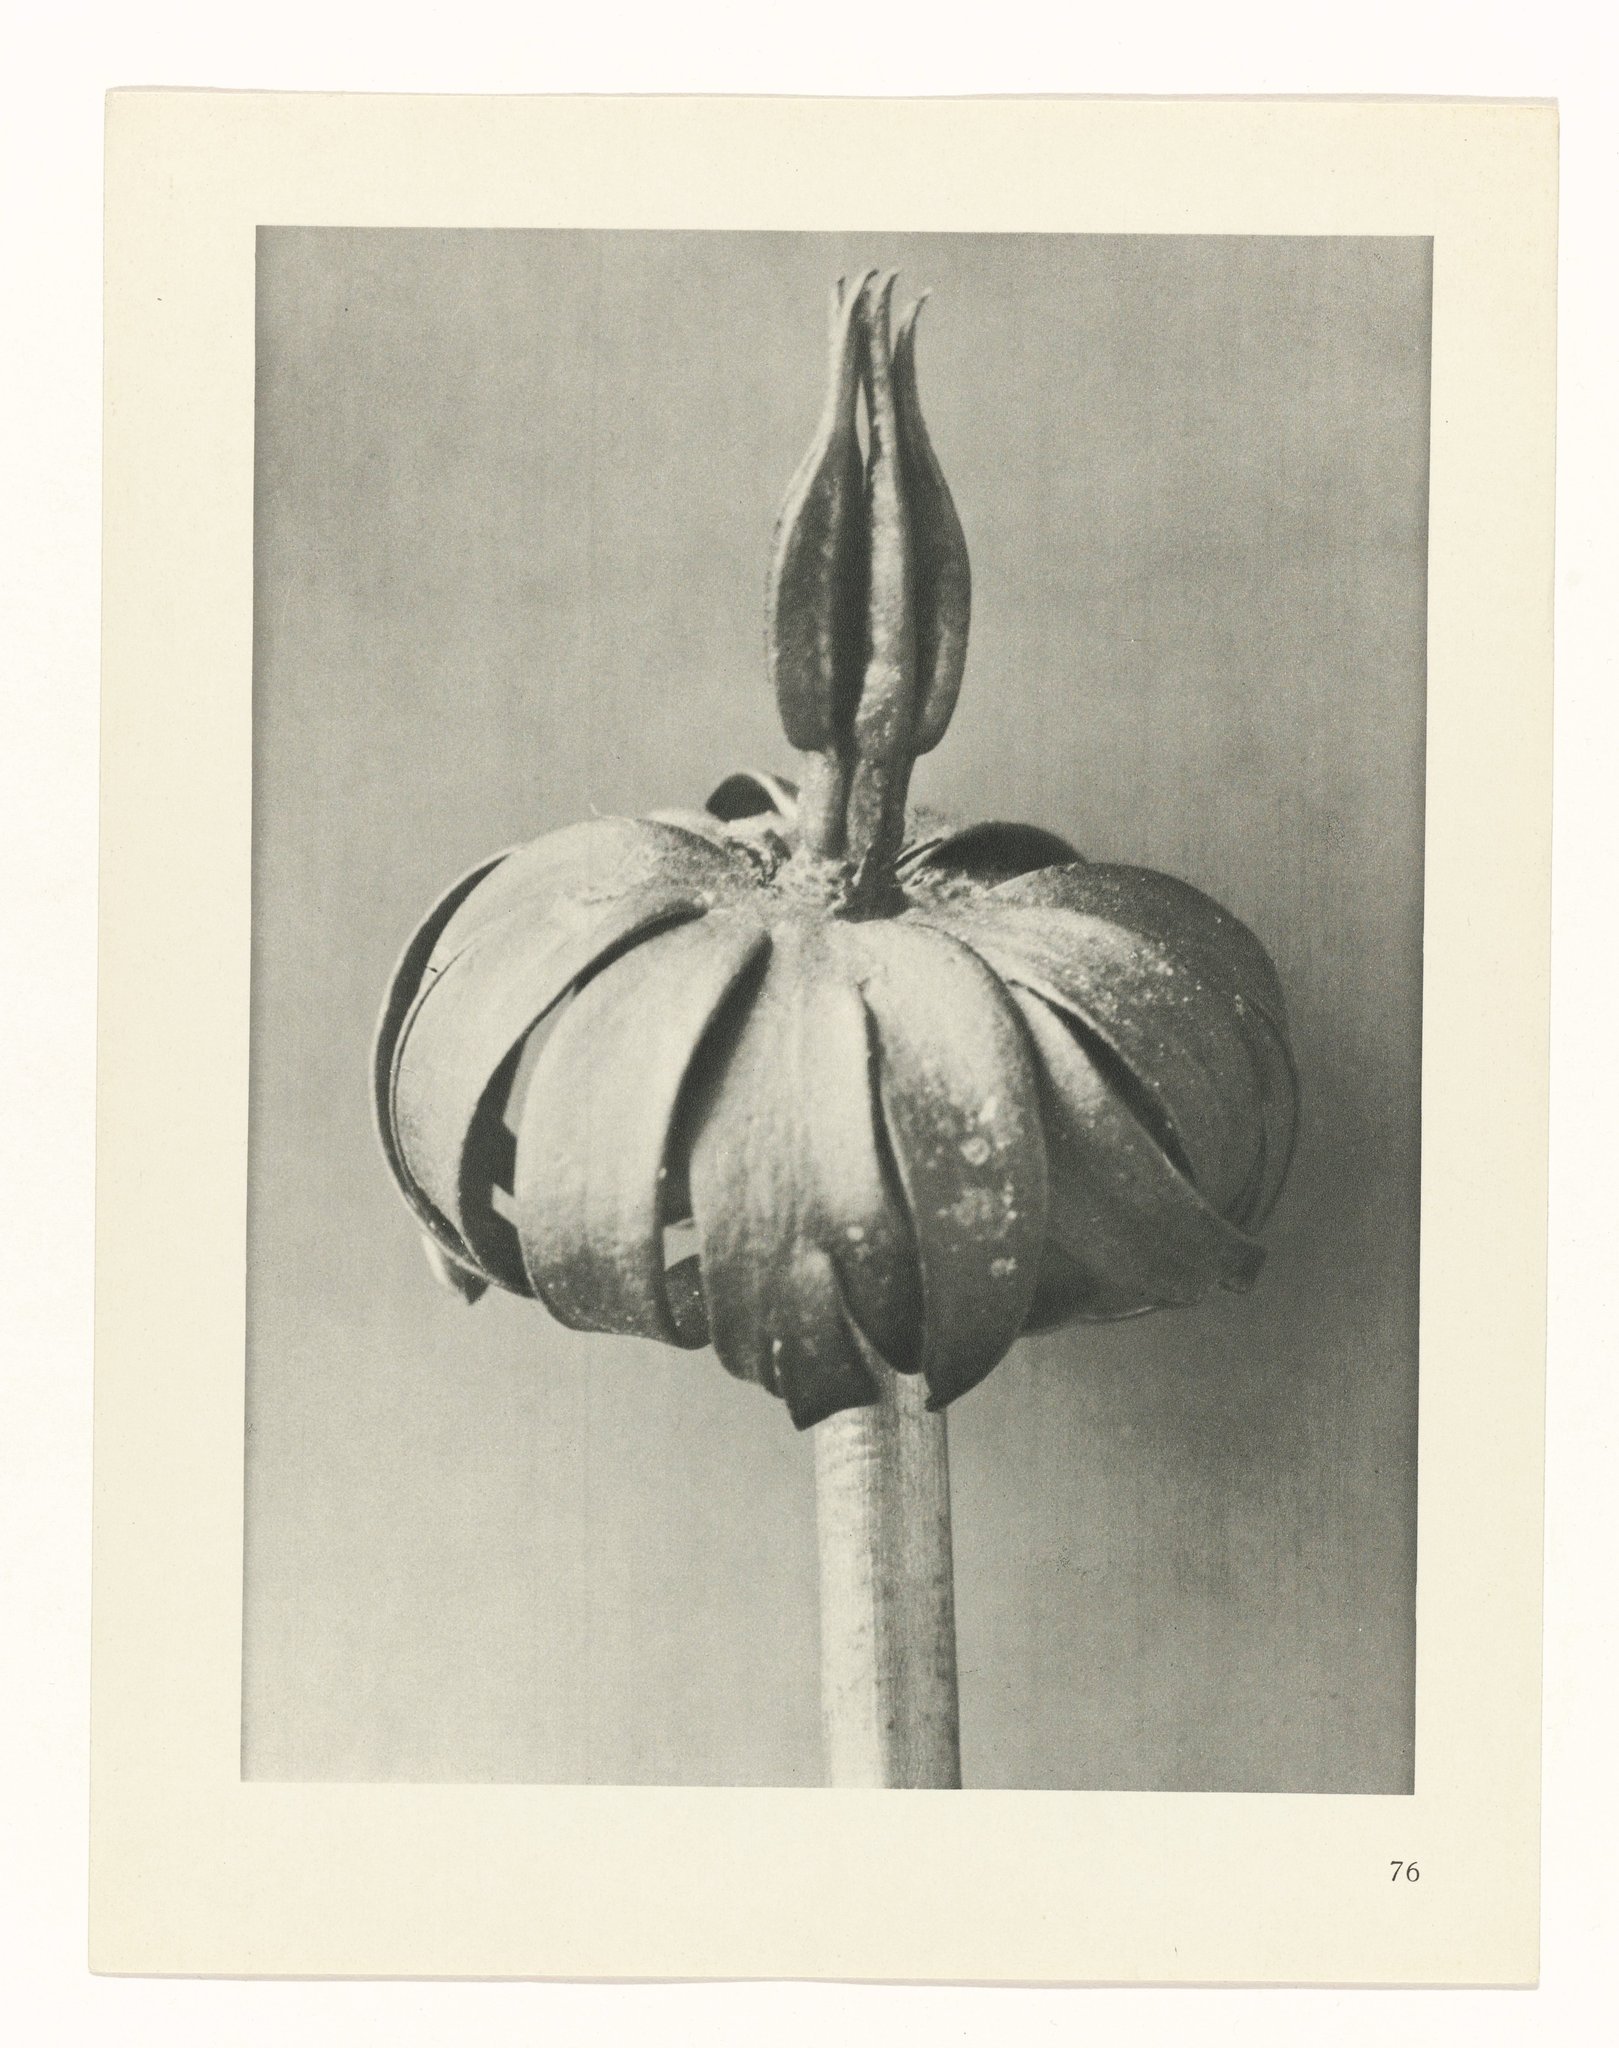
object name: photograph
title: Urformen der Kunst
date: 1928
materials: ink, paper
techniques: rotogravure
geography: berlin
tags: plants (in general)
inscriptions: number: ‘76’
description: facher Vergrößerung. Afkomstig uit losbladige uitgave.